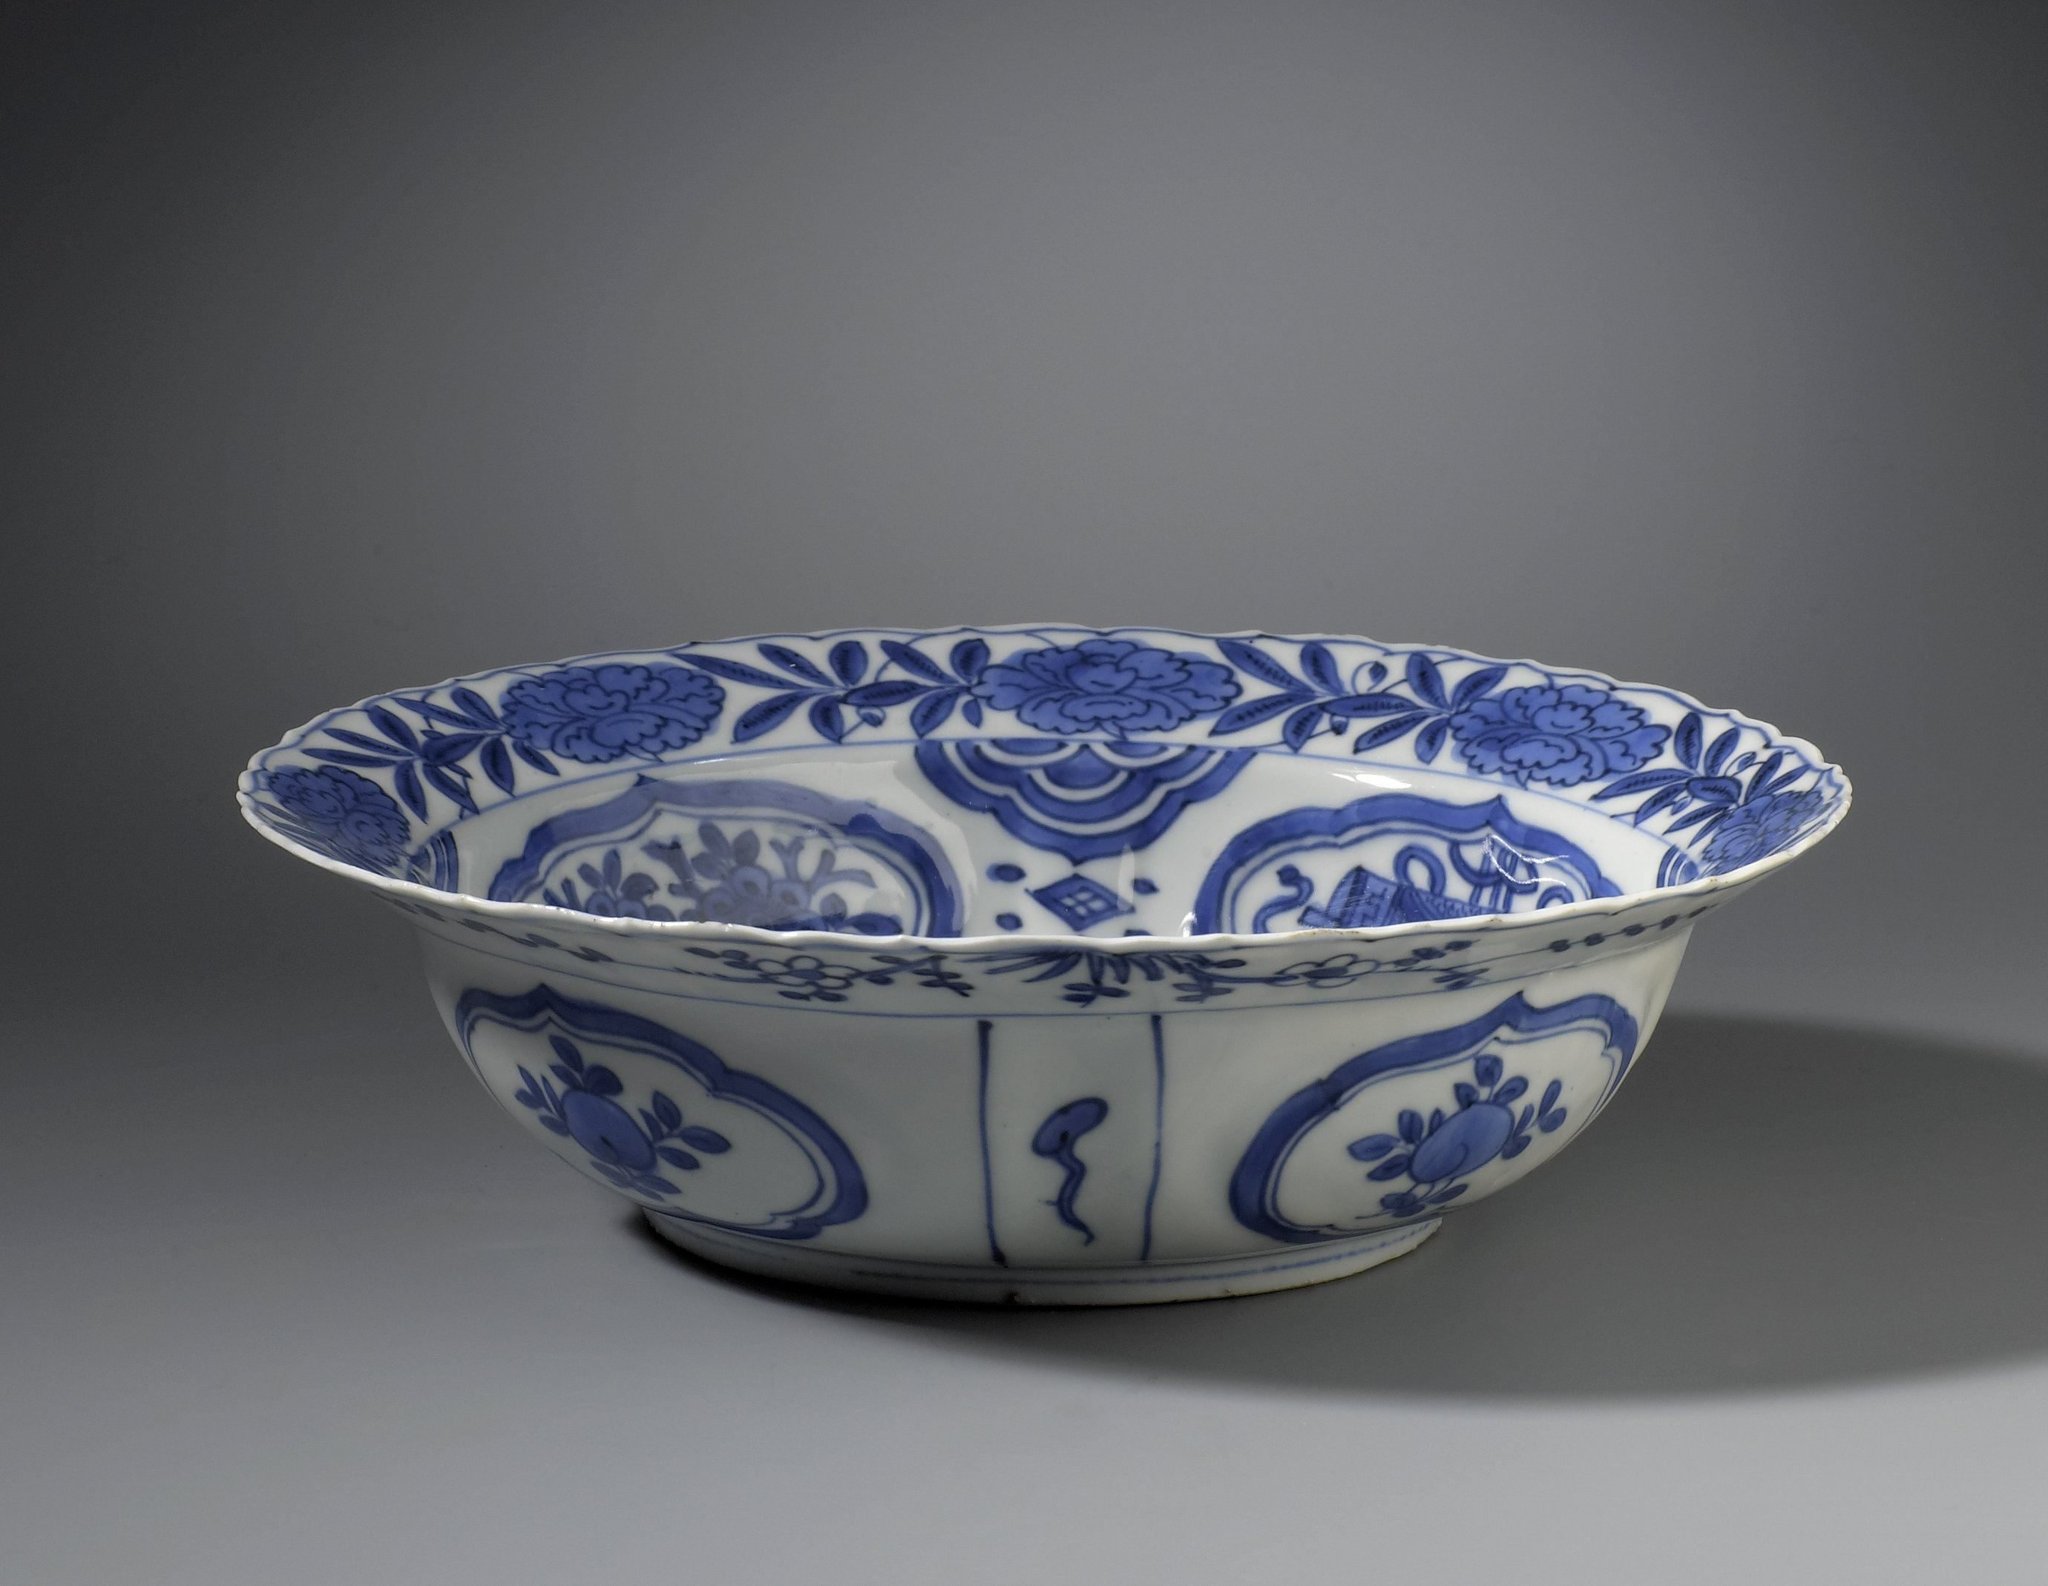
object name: klapmuts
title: Klapmuts bowl with two deer in a landscape near a pine tree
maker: Anonymous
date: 1600-1624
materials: cobalt, glaze, paint, porcelain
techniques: firing, turning, vitrification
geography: china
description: Klapmutskom gedecoreerd in onderglazuur blauw. Twee herten bij een pijnboom in een waterlandschap in het plat. Op de zijden een indeling in vakken met bloeiende planten en geluksymbolen; op de rand bloemtakken.